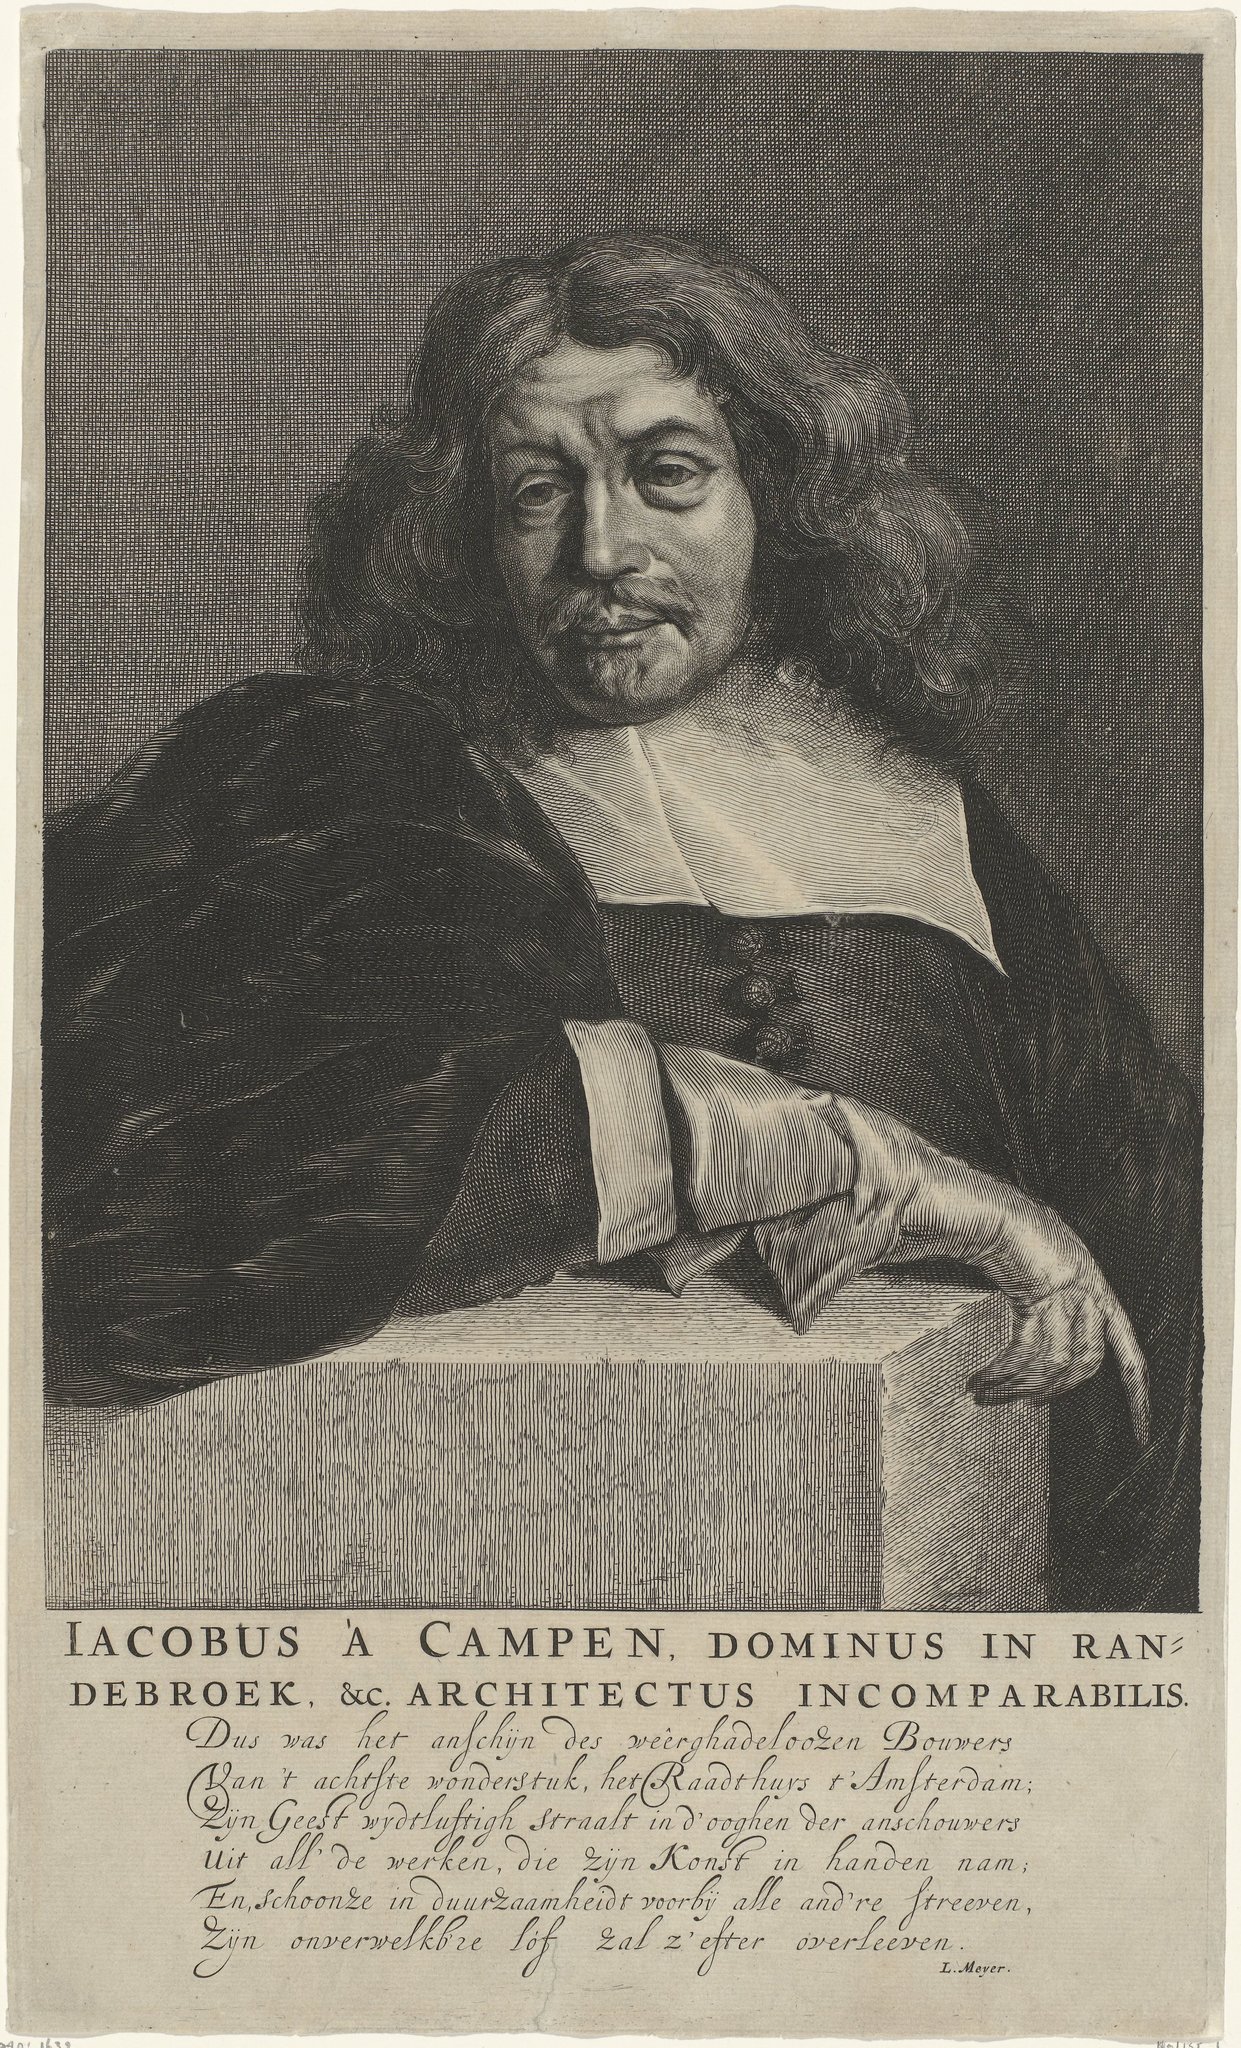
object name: print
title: Portret van Jacob van Campen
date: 1650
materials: paper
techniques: engraving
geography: amsterdam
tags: print maker, draughtsman, jacob van campen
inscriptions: collector's mark: Lugt 2760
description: Portret van Jacob van Campen, architect van het Amsterdamse stadhuis. In de marge een Nederlands lofdicht.